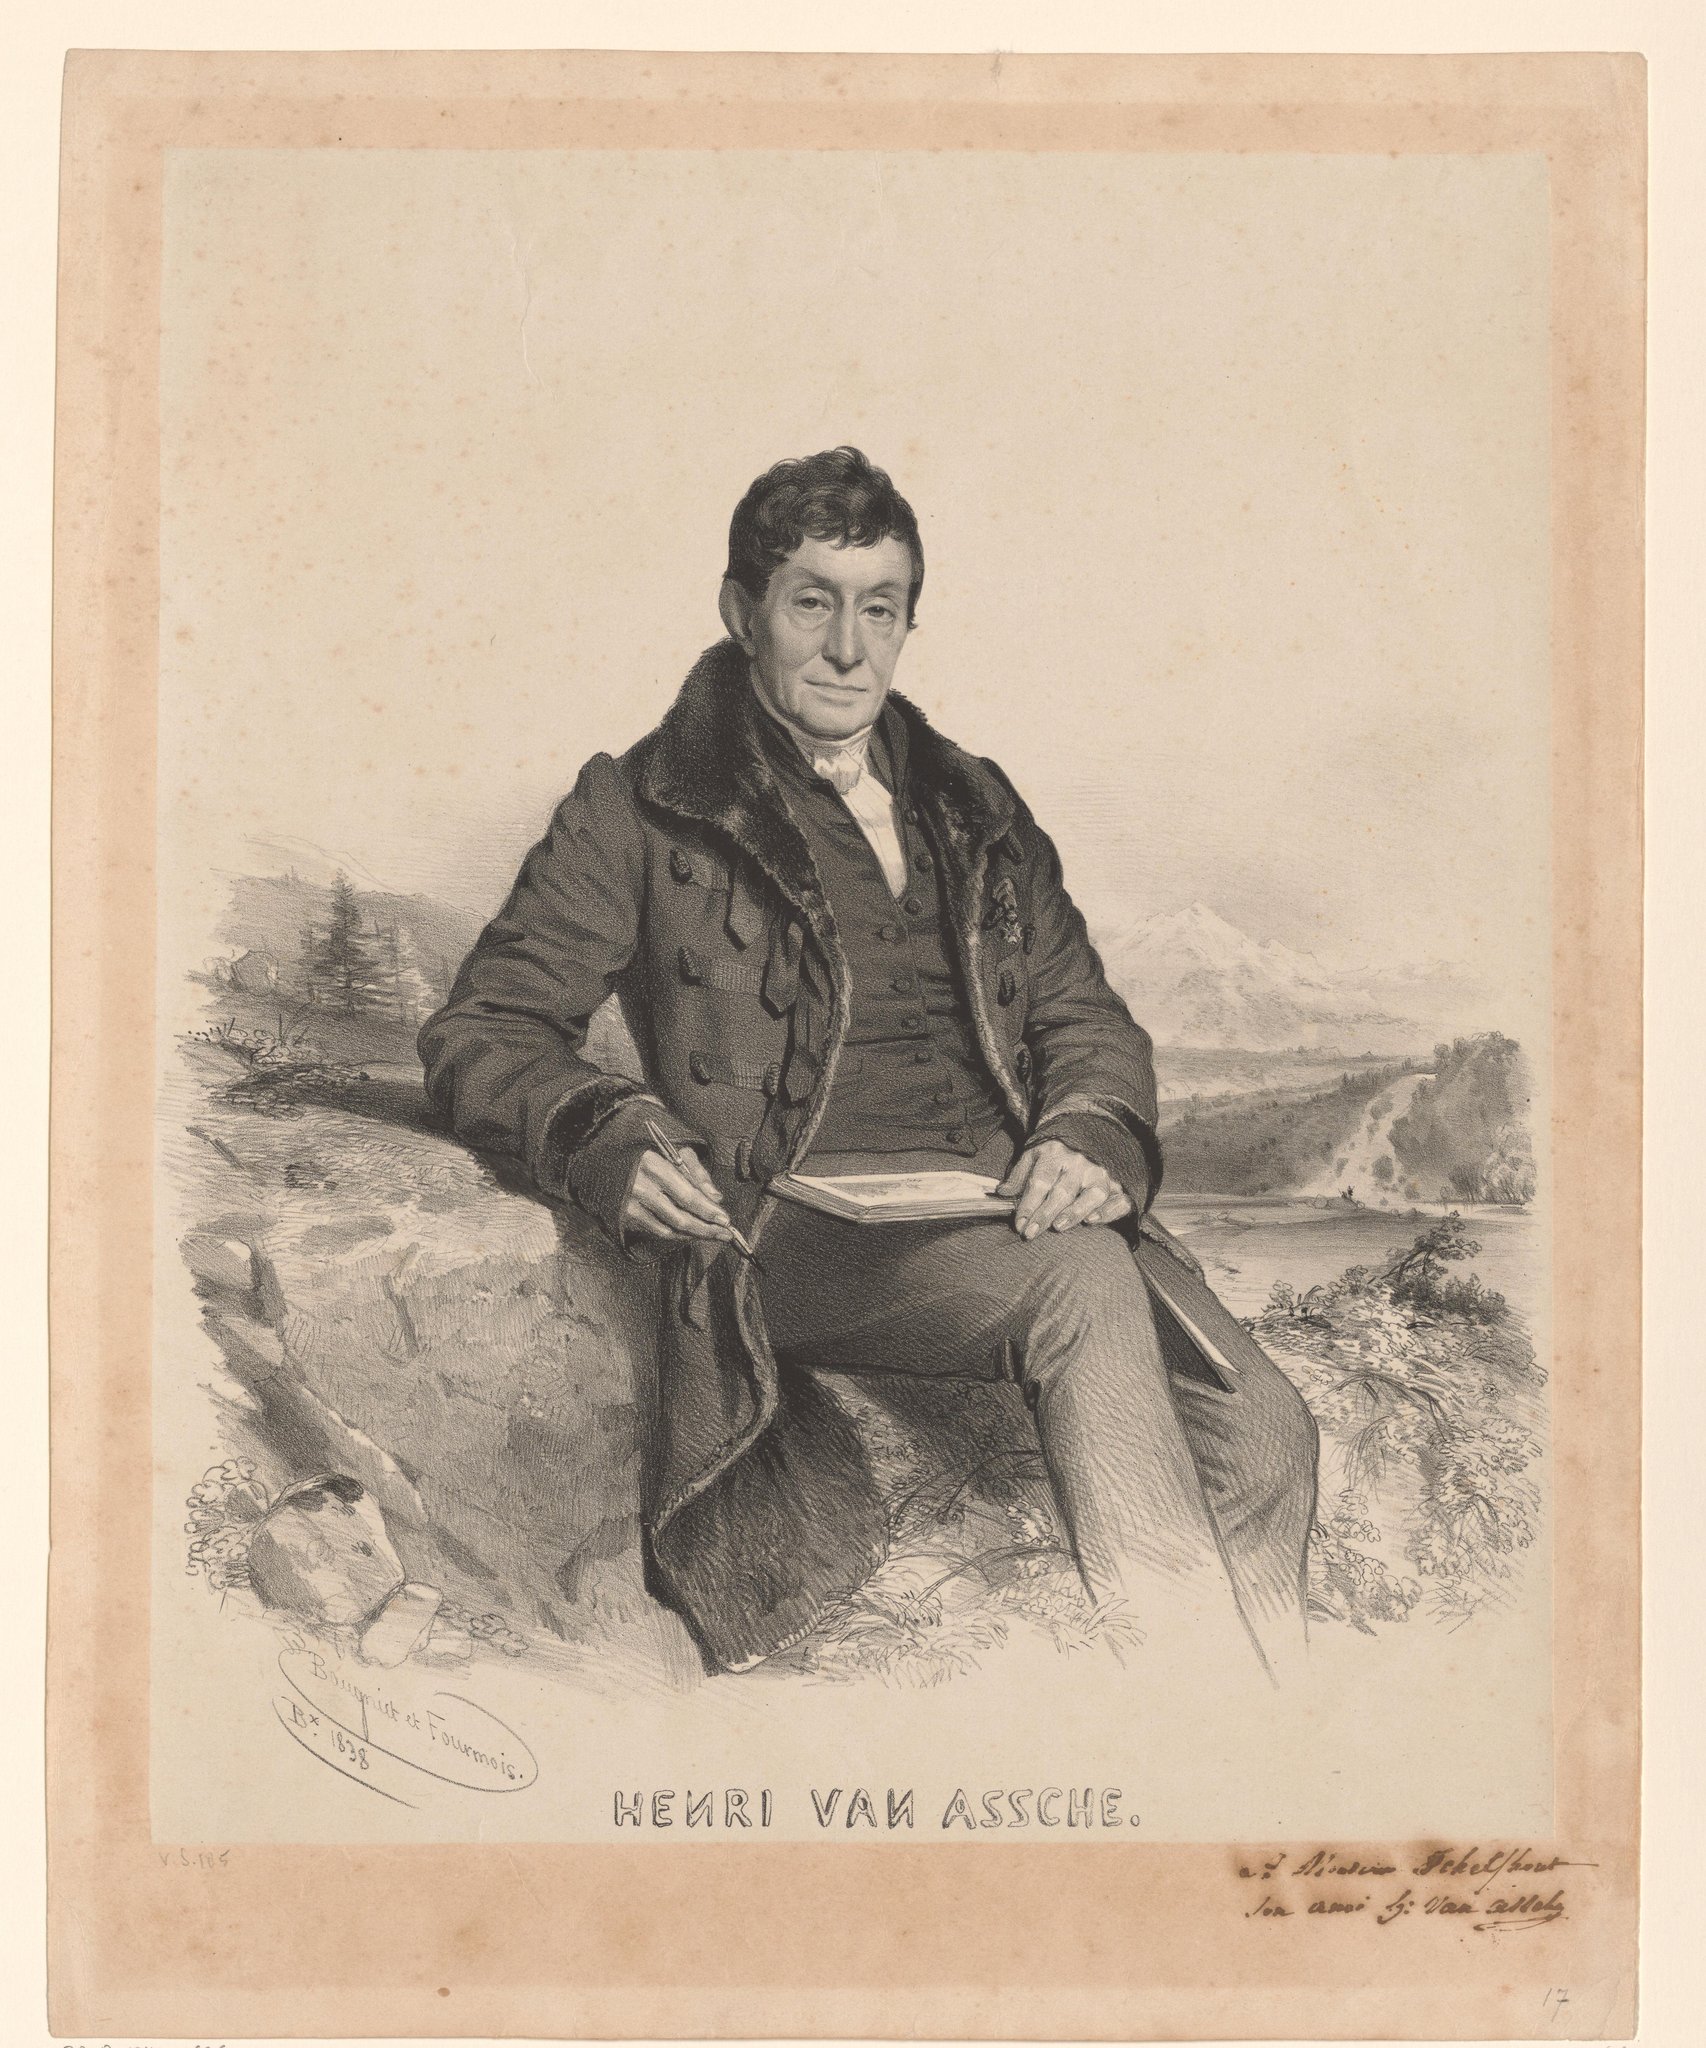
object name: print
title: Portret van Henri van Assche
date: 1838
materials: paper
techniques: lithograph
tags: brussels, print maker, henri van assche, landscapes, historical persons, portrait, self-portrait of painter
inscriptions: collector's mark: Lugt 2760, collector's mark: Lugt 2166, inscription: ‘A [...] Schelfhout/ ton ami S: van [...]’, collector's mark: Lugt 2228